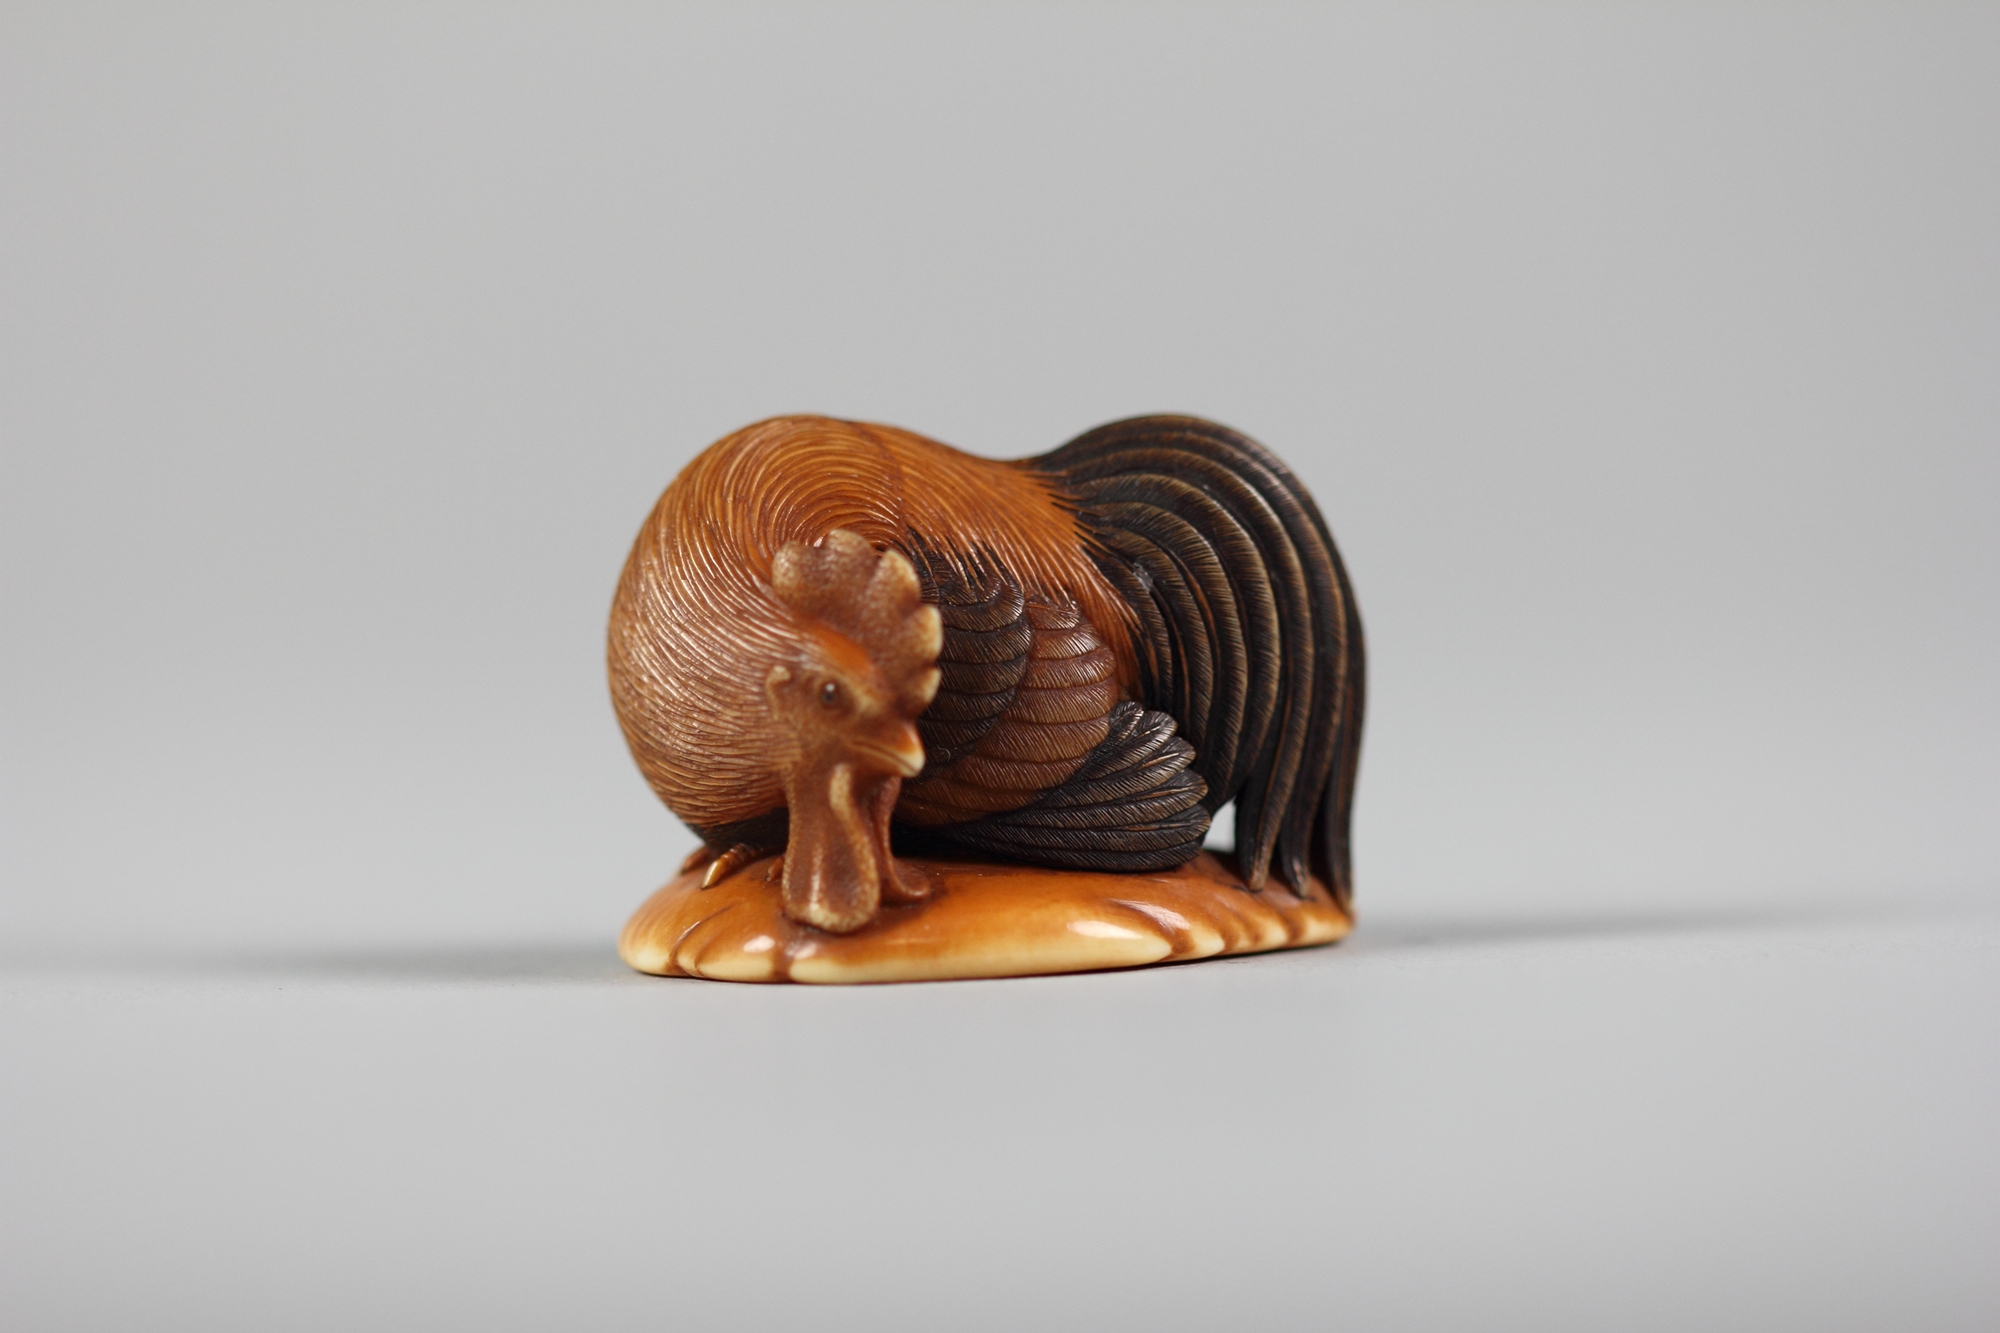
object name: netsuke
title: Netsuke of a Chicken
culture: japanese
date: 1867-1900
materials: ivory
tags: roosters